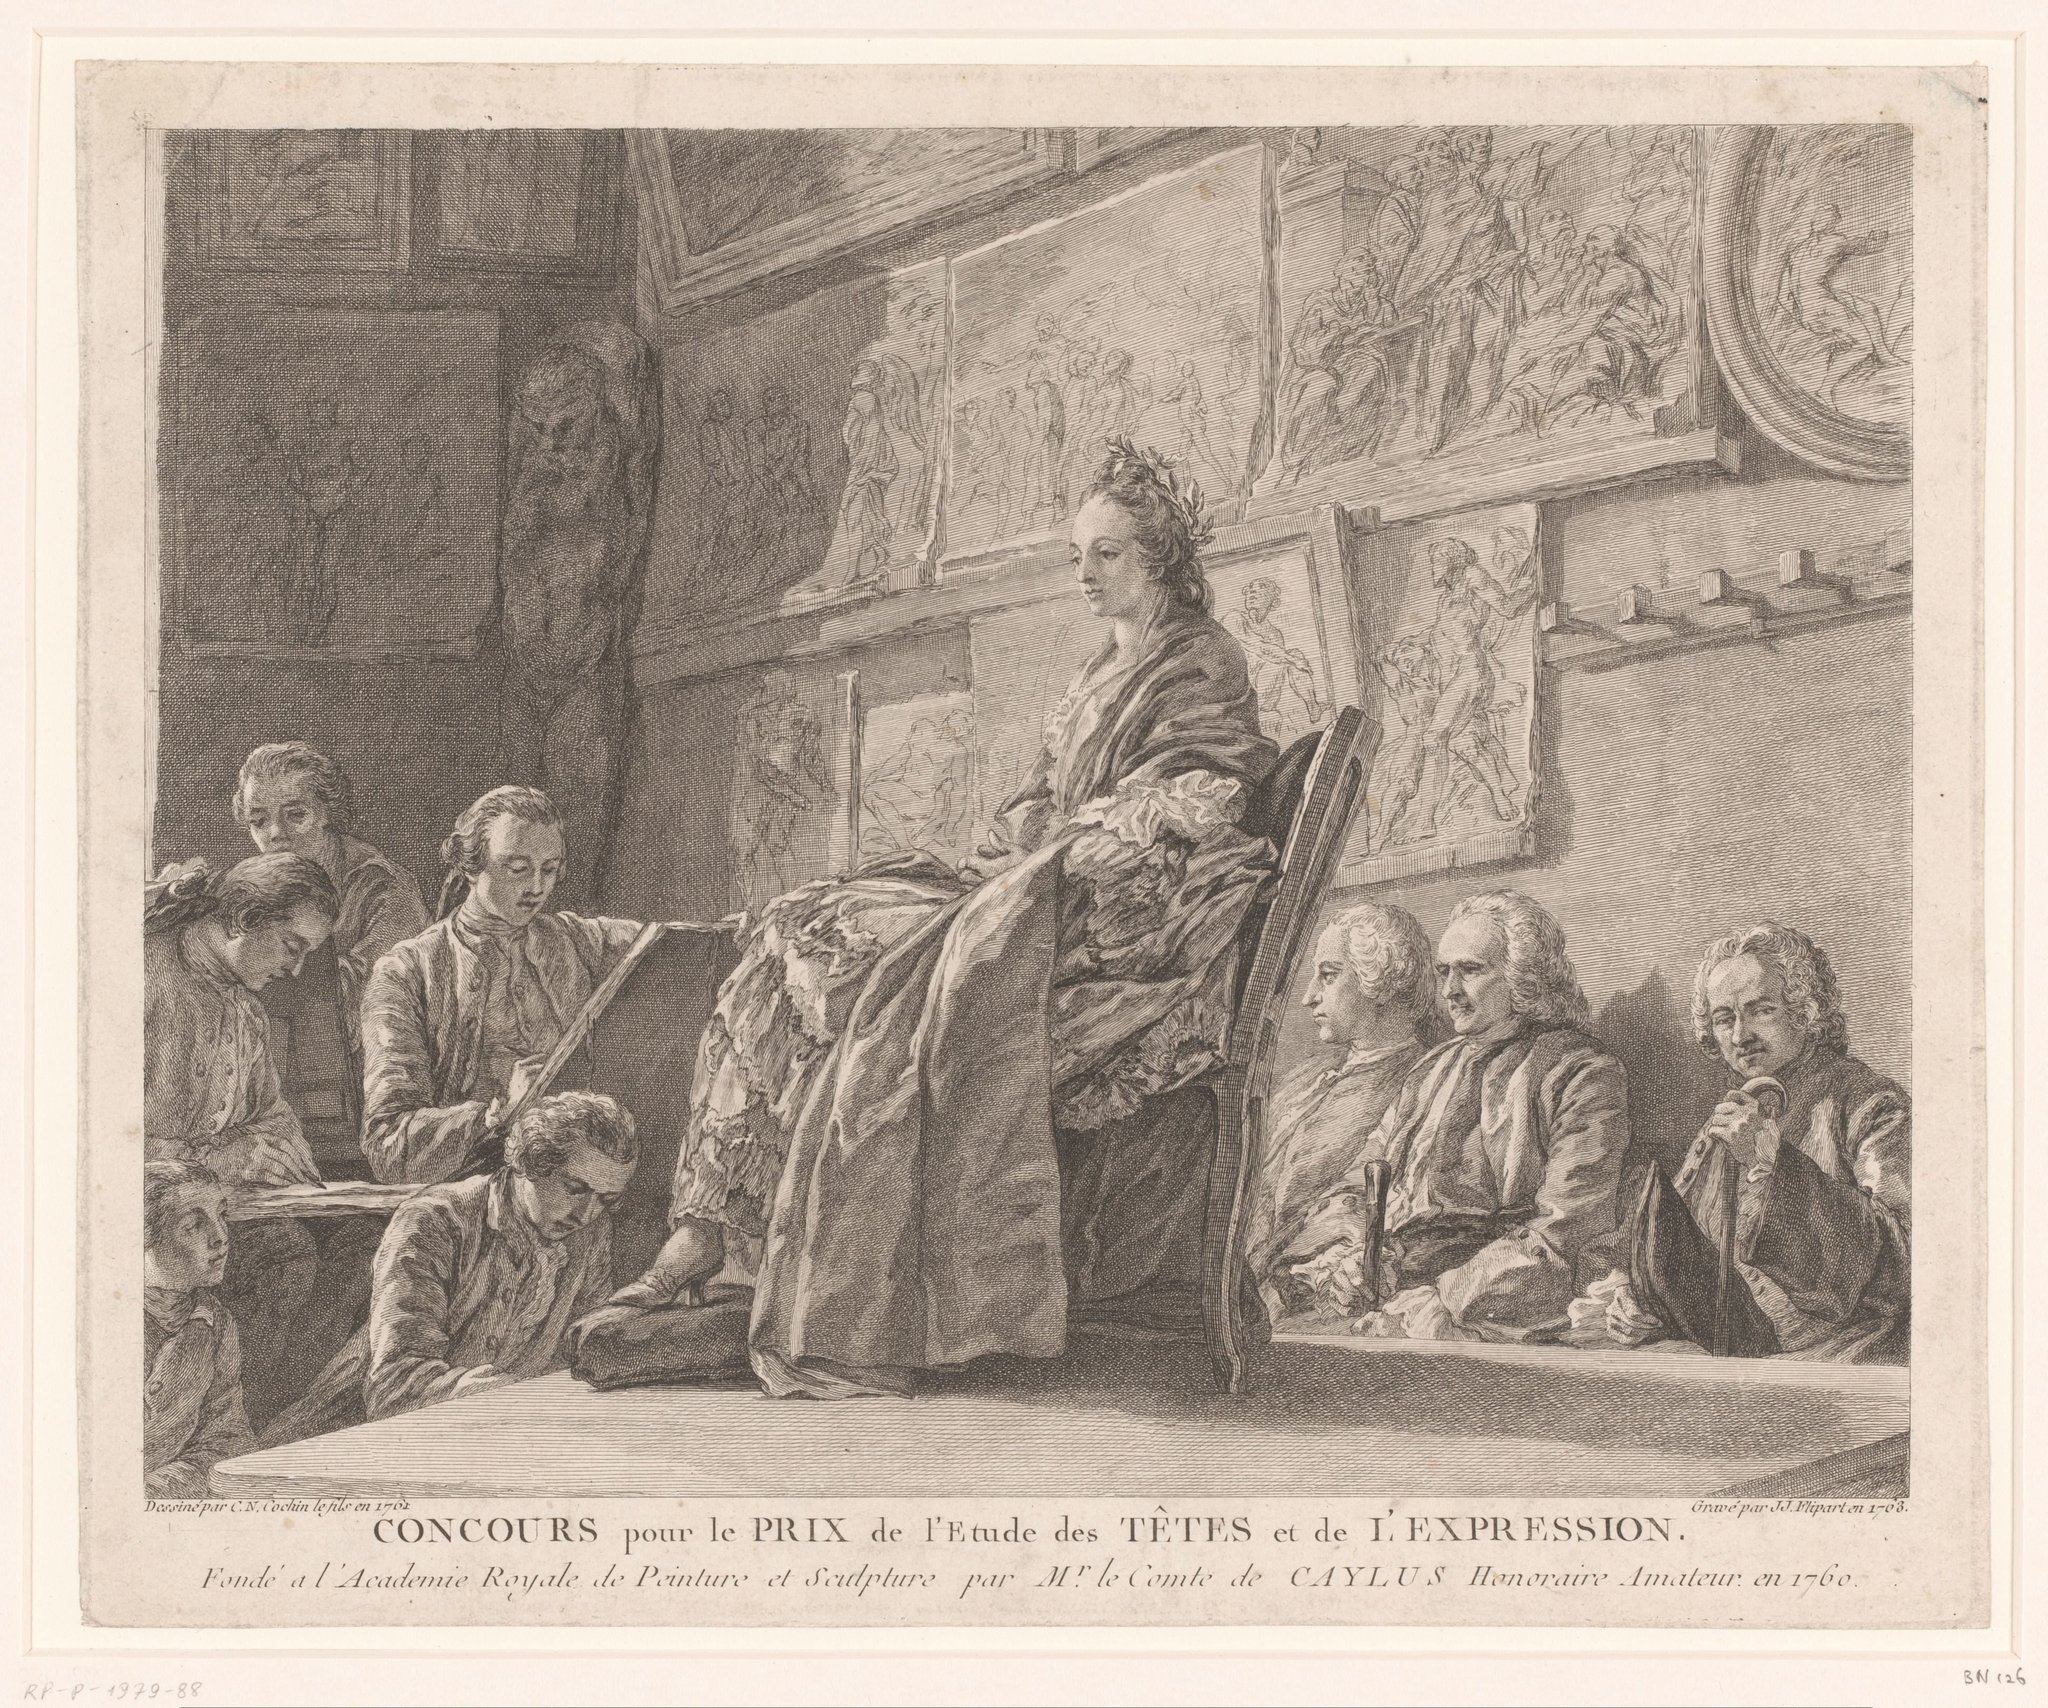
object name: print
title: Tekenen naar levend model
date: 1763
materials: paper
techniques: engraving, etching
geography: france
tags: place or institution of education and training of the artist, e.g.: academy of art, competition, art contest, artist (in general) working from clothed model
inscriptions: date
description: Poserende dame, zittend op een stoel op een verhoging, voorstellende 'La Douceur', het thema van het Concours pour le prix de l'Etude des têtes et de l'expression van de Académie Royale in 1761. Vier deelnemers aan de prijsvraag van 1761 tekenen het portret van de poserende dame. Rechts zit de jury: de schilder Vassé (links), de Comte de Caylus (midden) en Jean Restout, directeur van de Academie (rechts). Aan de muur hangen schilderijen boven elkaar. Het doel van deze in 1759 ingestelde jaarlijkse prijsvraag was het stimuleren van het tekenen van de menselijke emoties als onderdeel van het tekenprogramma. De deelnemers moesten een levensgrote kop schilderen, tekenen of modelleren in reliëf, gebaseerd op het model dat werd gekozen door de Academie.